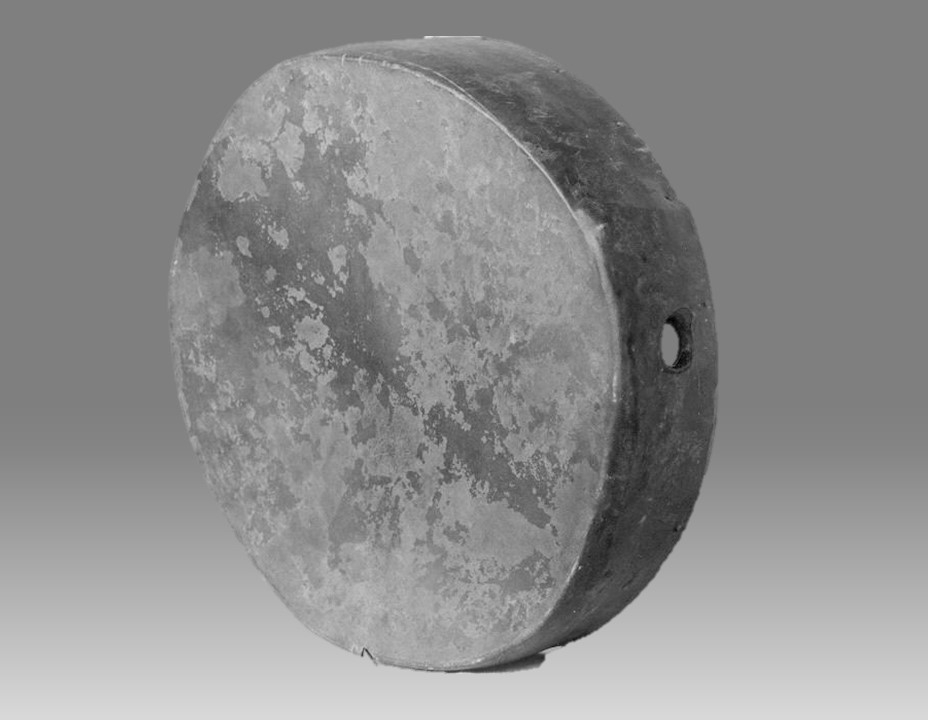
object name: bendir frame drum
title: Bendir (frame drum)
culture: moroccan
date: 1867-1900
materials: parchment, wood